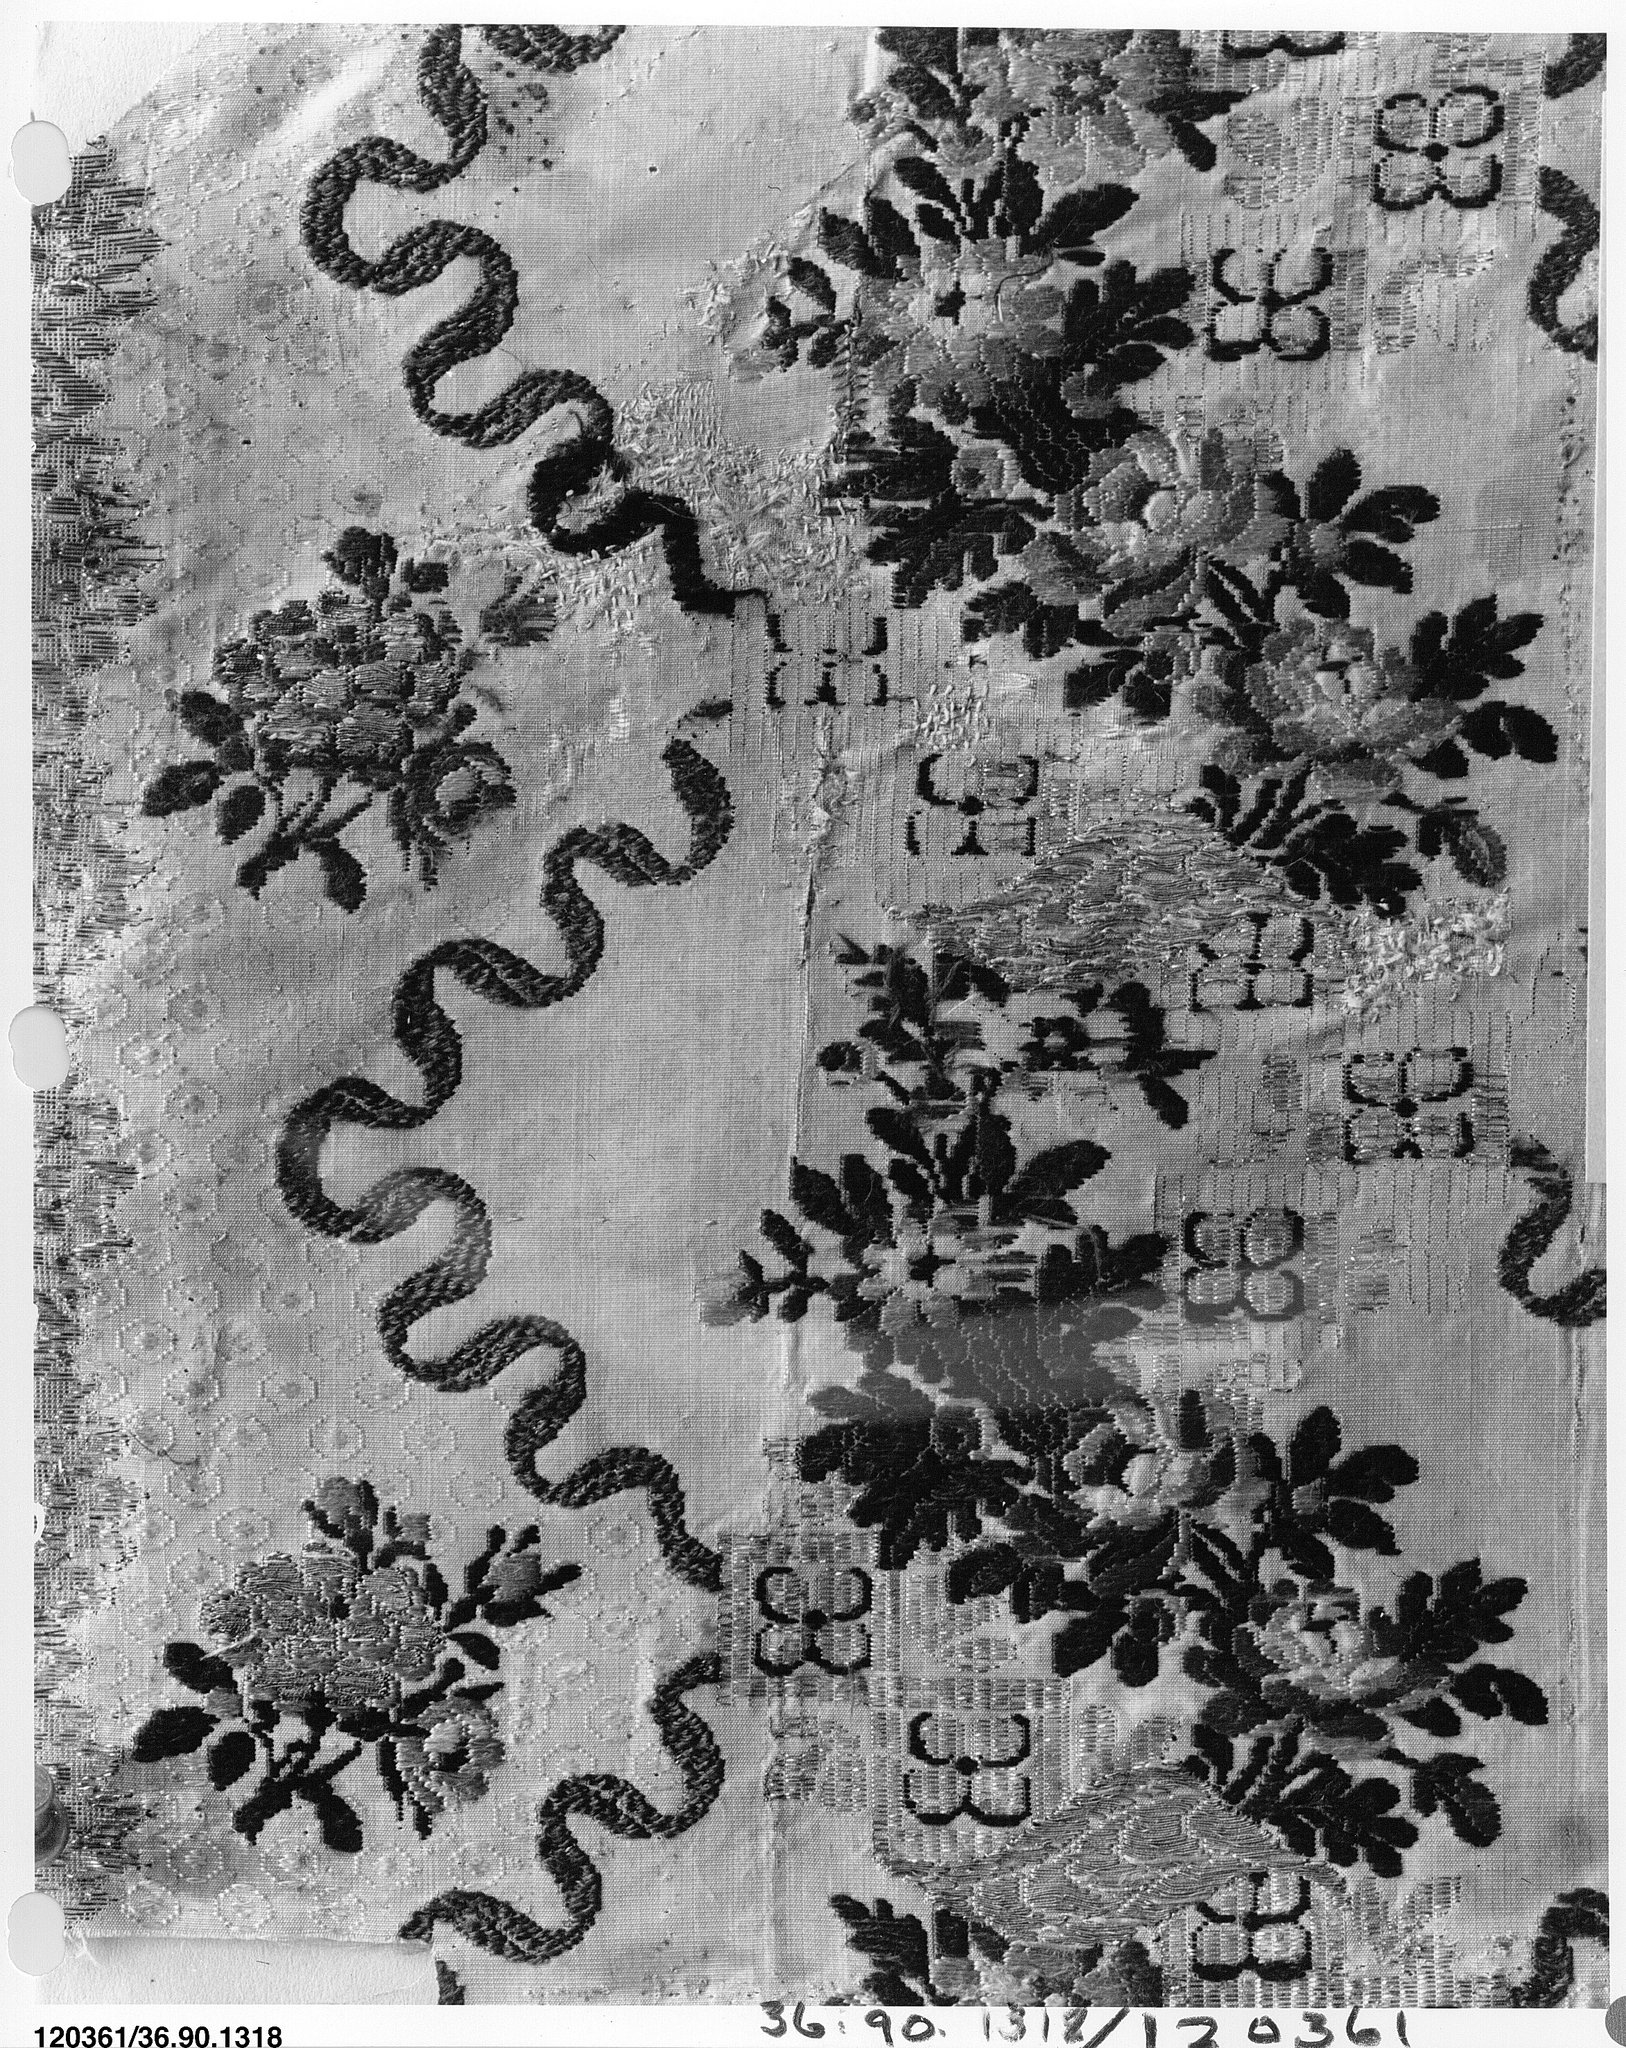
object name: piece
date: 1750-1760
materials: metal thread, silk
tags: flowers,leaves